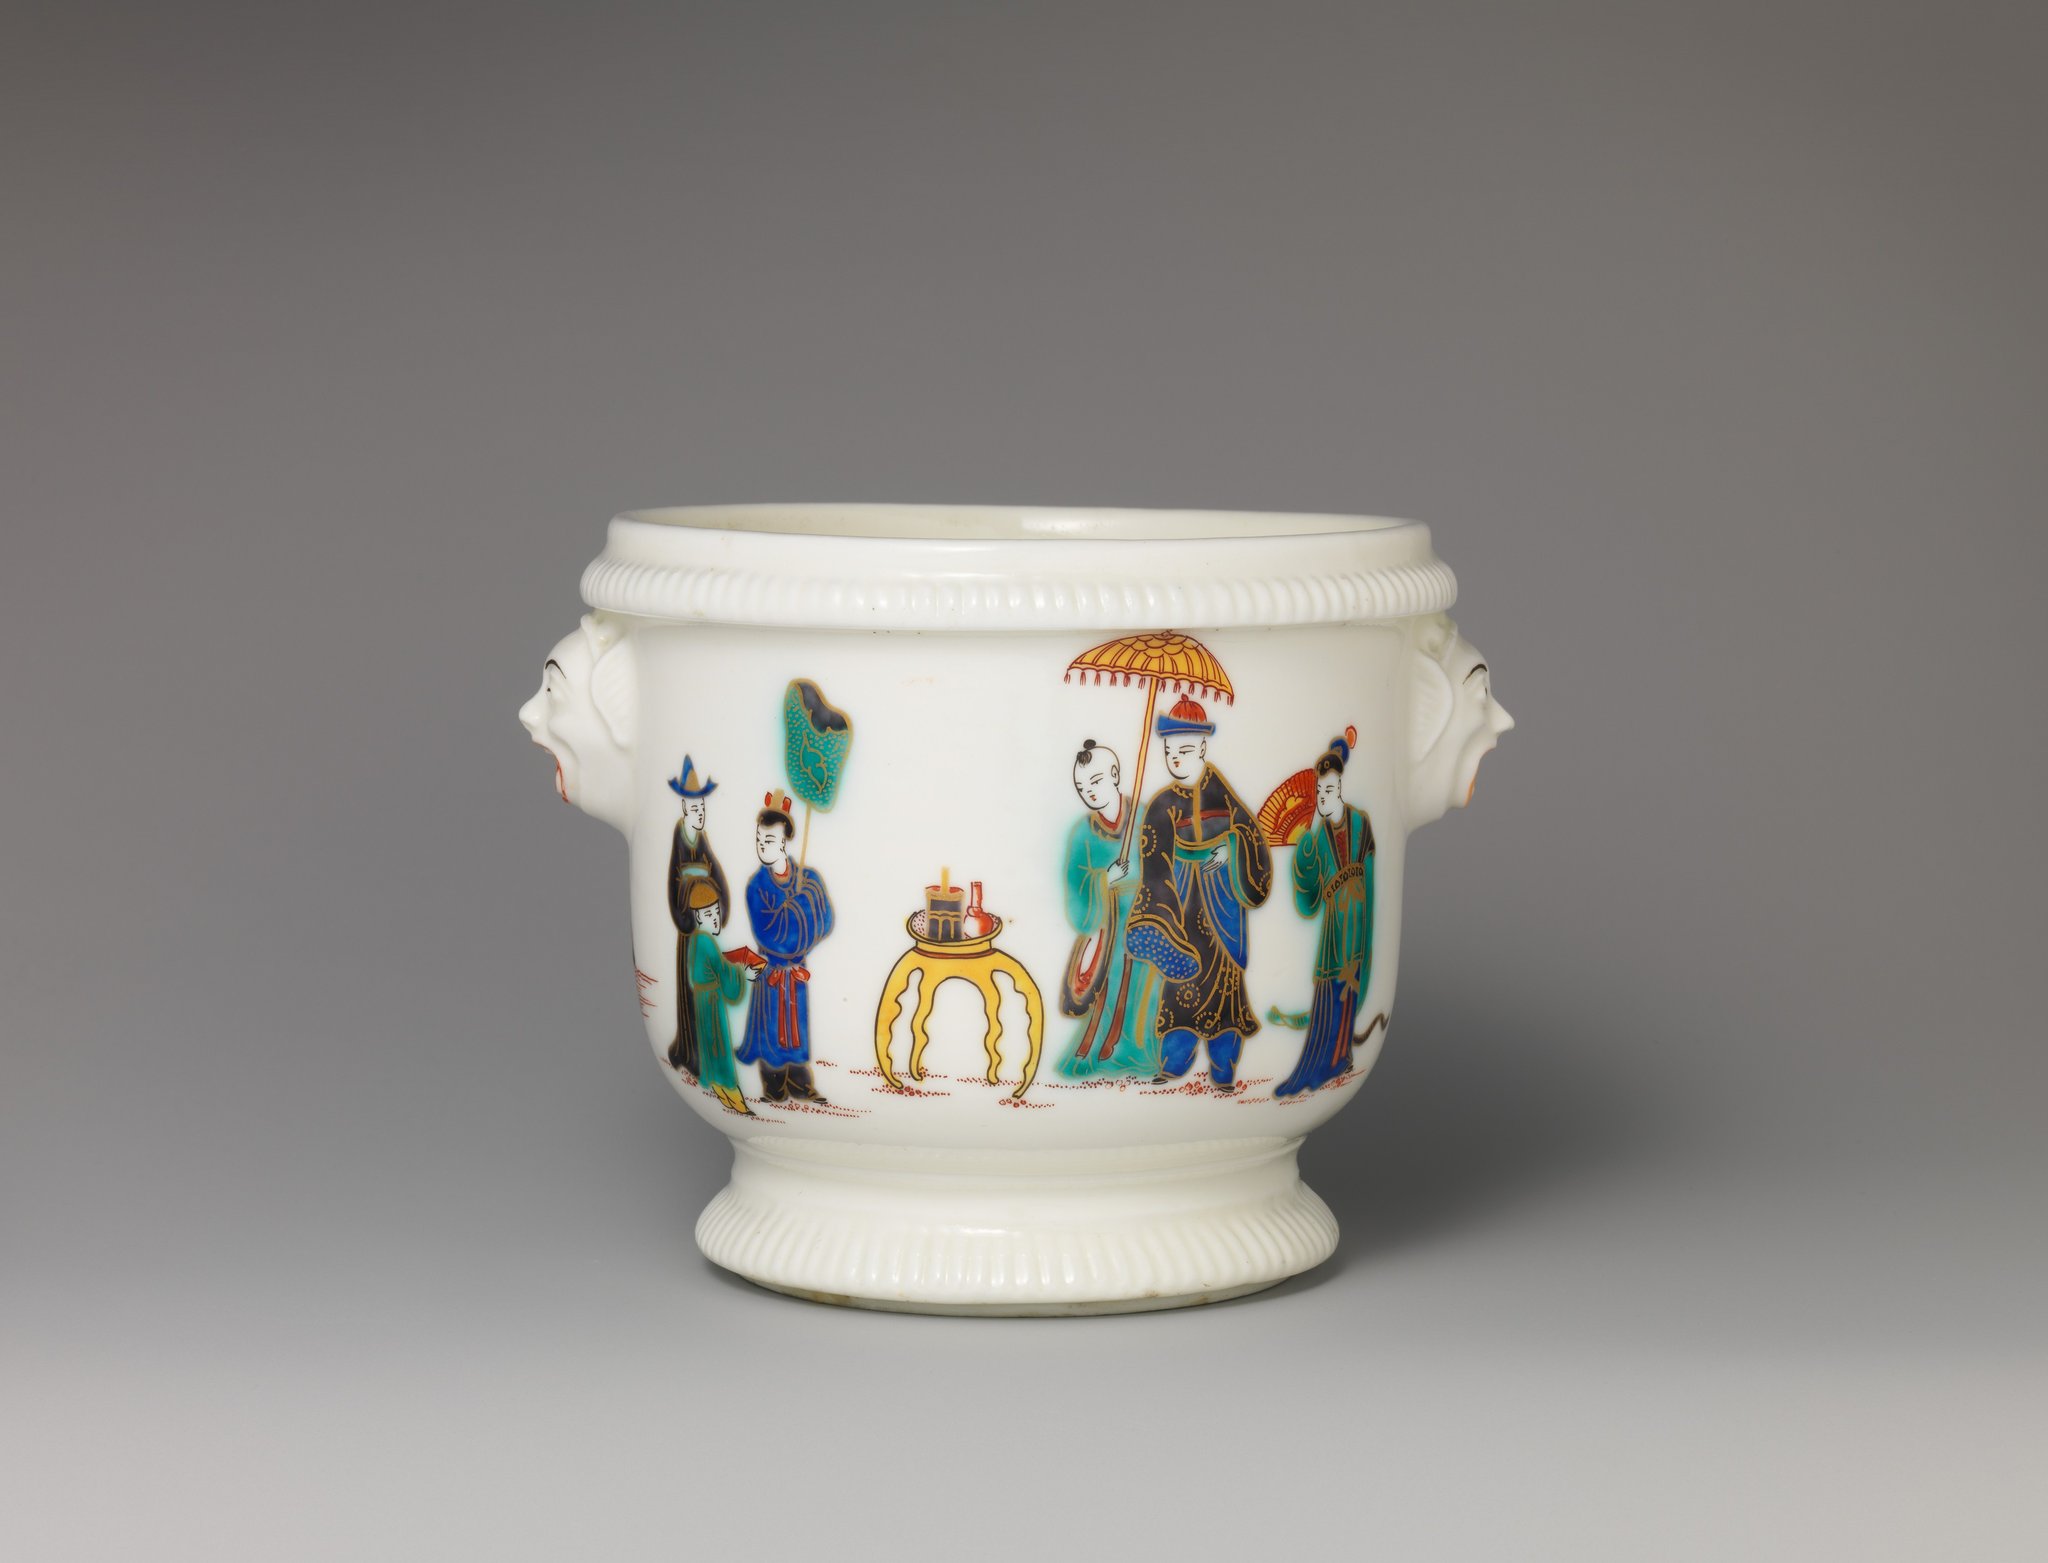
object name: glass cooler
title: Glass cooler (seau à verre)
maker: saint-cloud factory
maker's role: factory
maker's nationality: french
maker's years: 1693-1766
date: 1725-1730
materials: enamel, gold, soft paste porcelain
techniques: polychrome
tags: faces,men,women